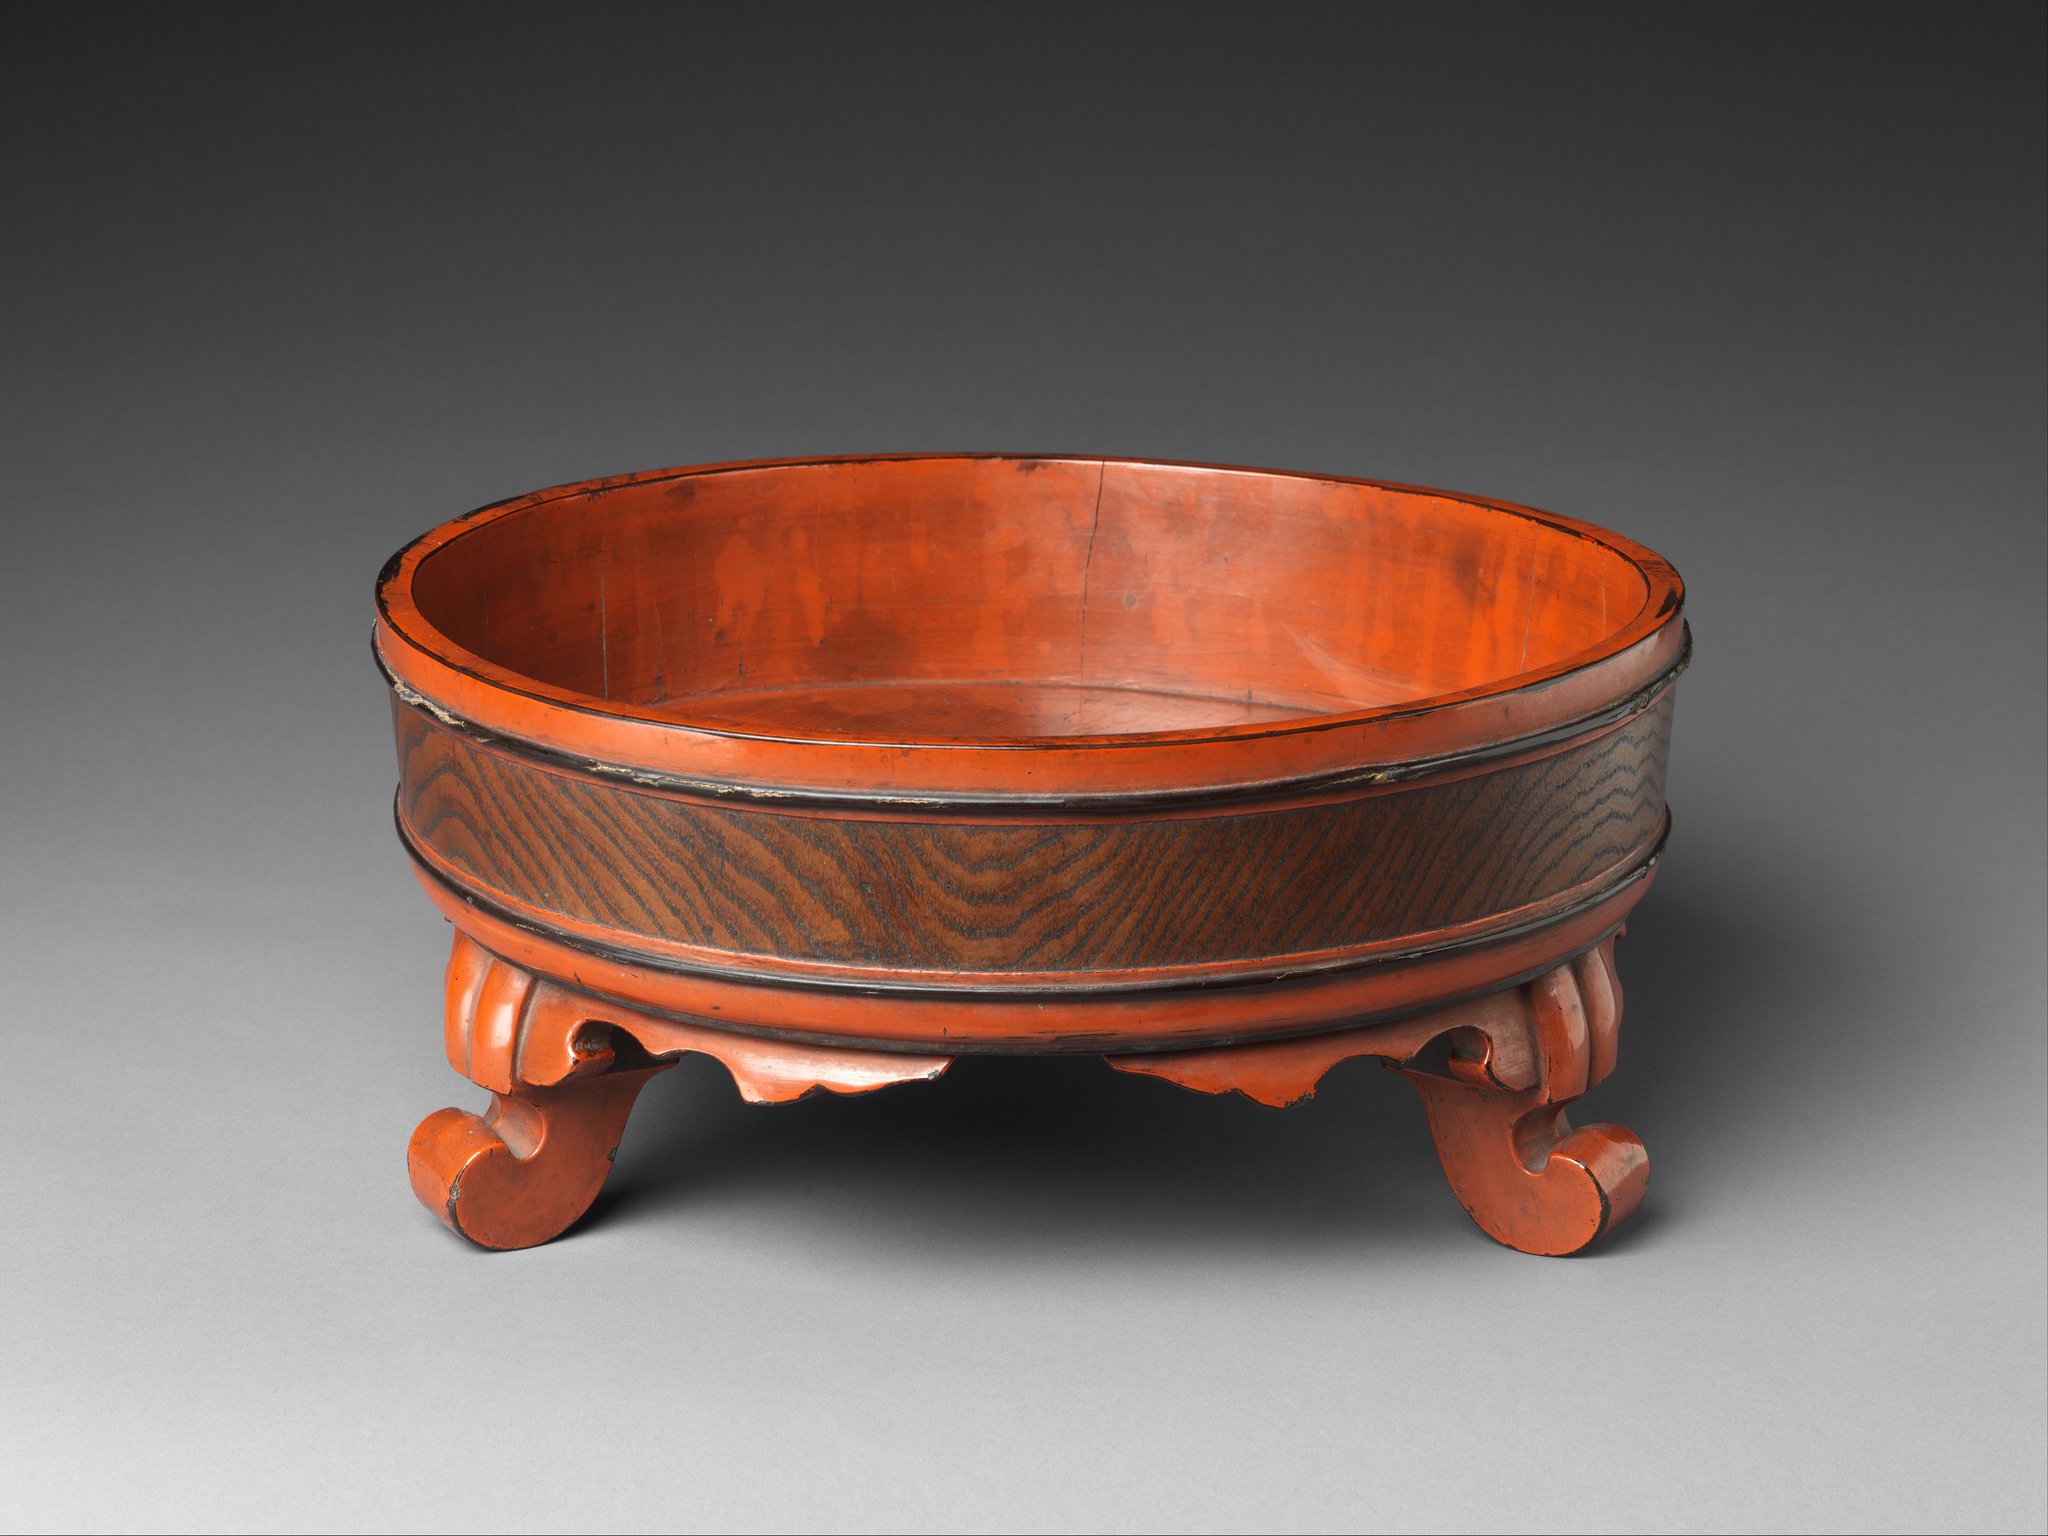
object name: basin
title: Ritual Wash Basin (Ashitsuki-darai)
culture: japanese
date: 1501-1600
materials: lacquer, wood